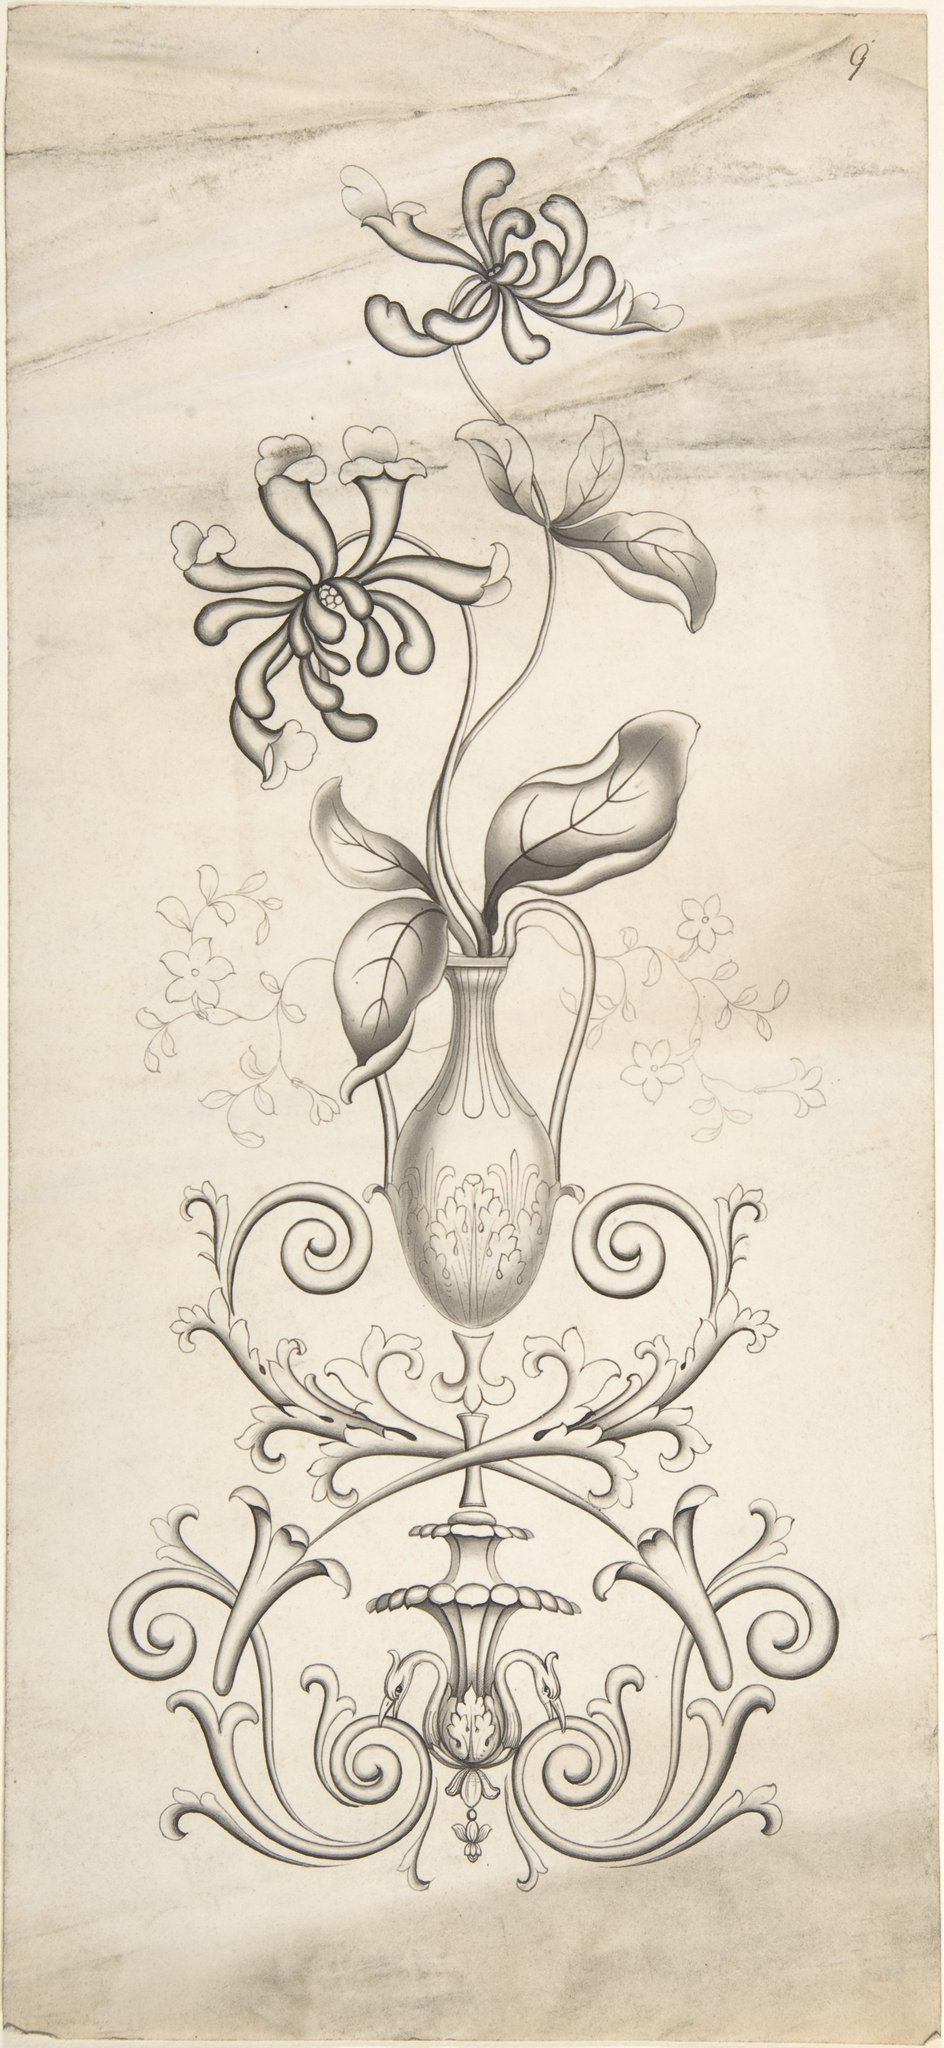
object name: drawing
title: Design for Panel Decoration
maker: j. hulme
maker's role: artist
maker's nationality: british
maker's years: 1800-1880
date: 1828-1840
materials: ink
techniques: brush, pen, wash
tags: flowers,leaves,vases